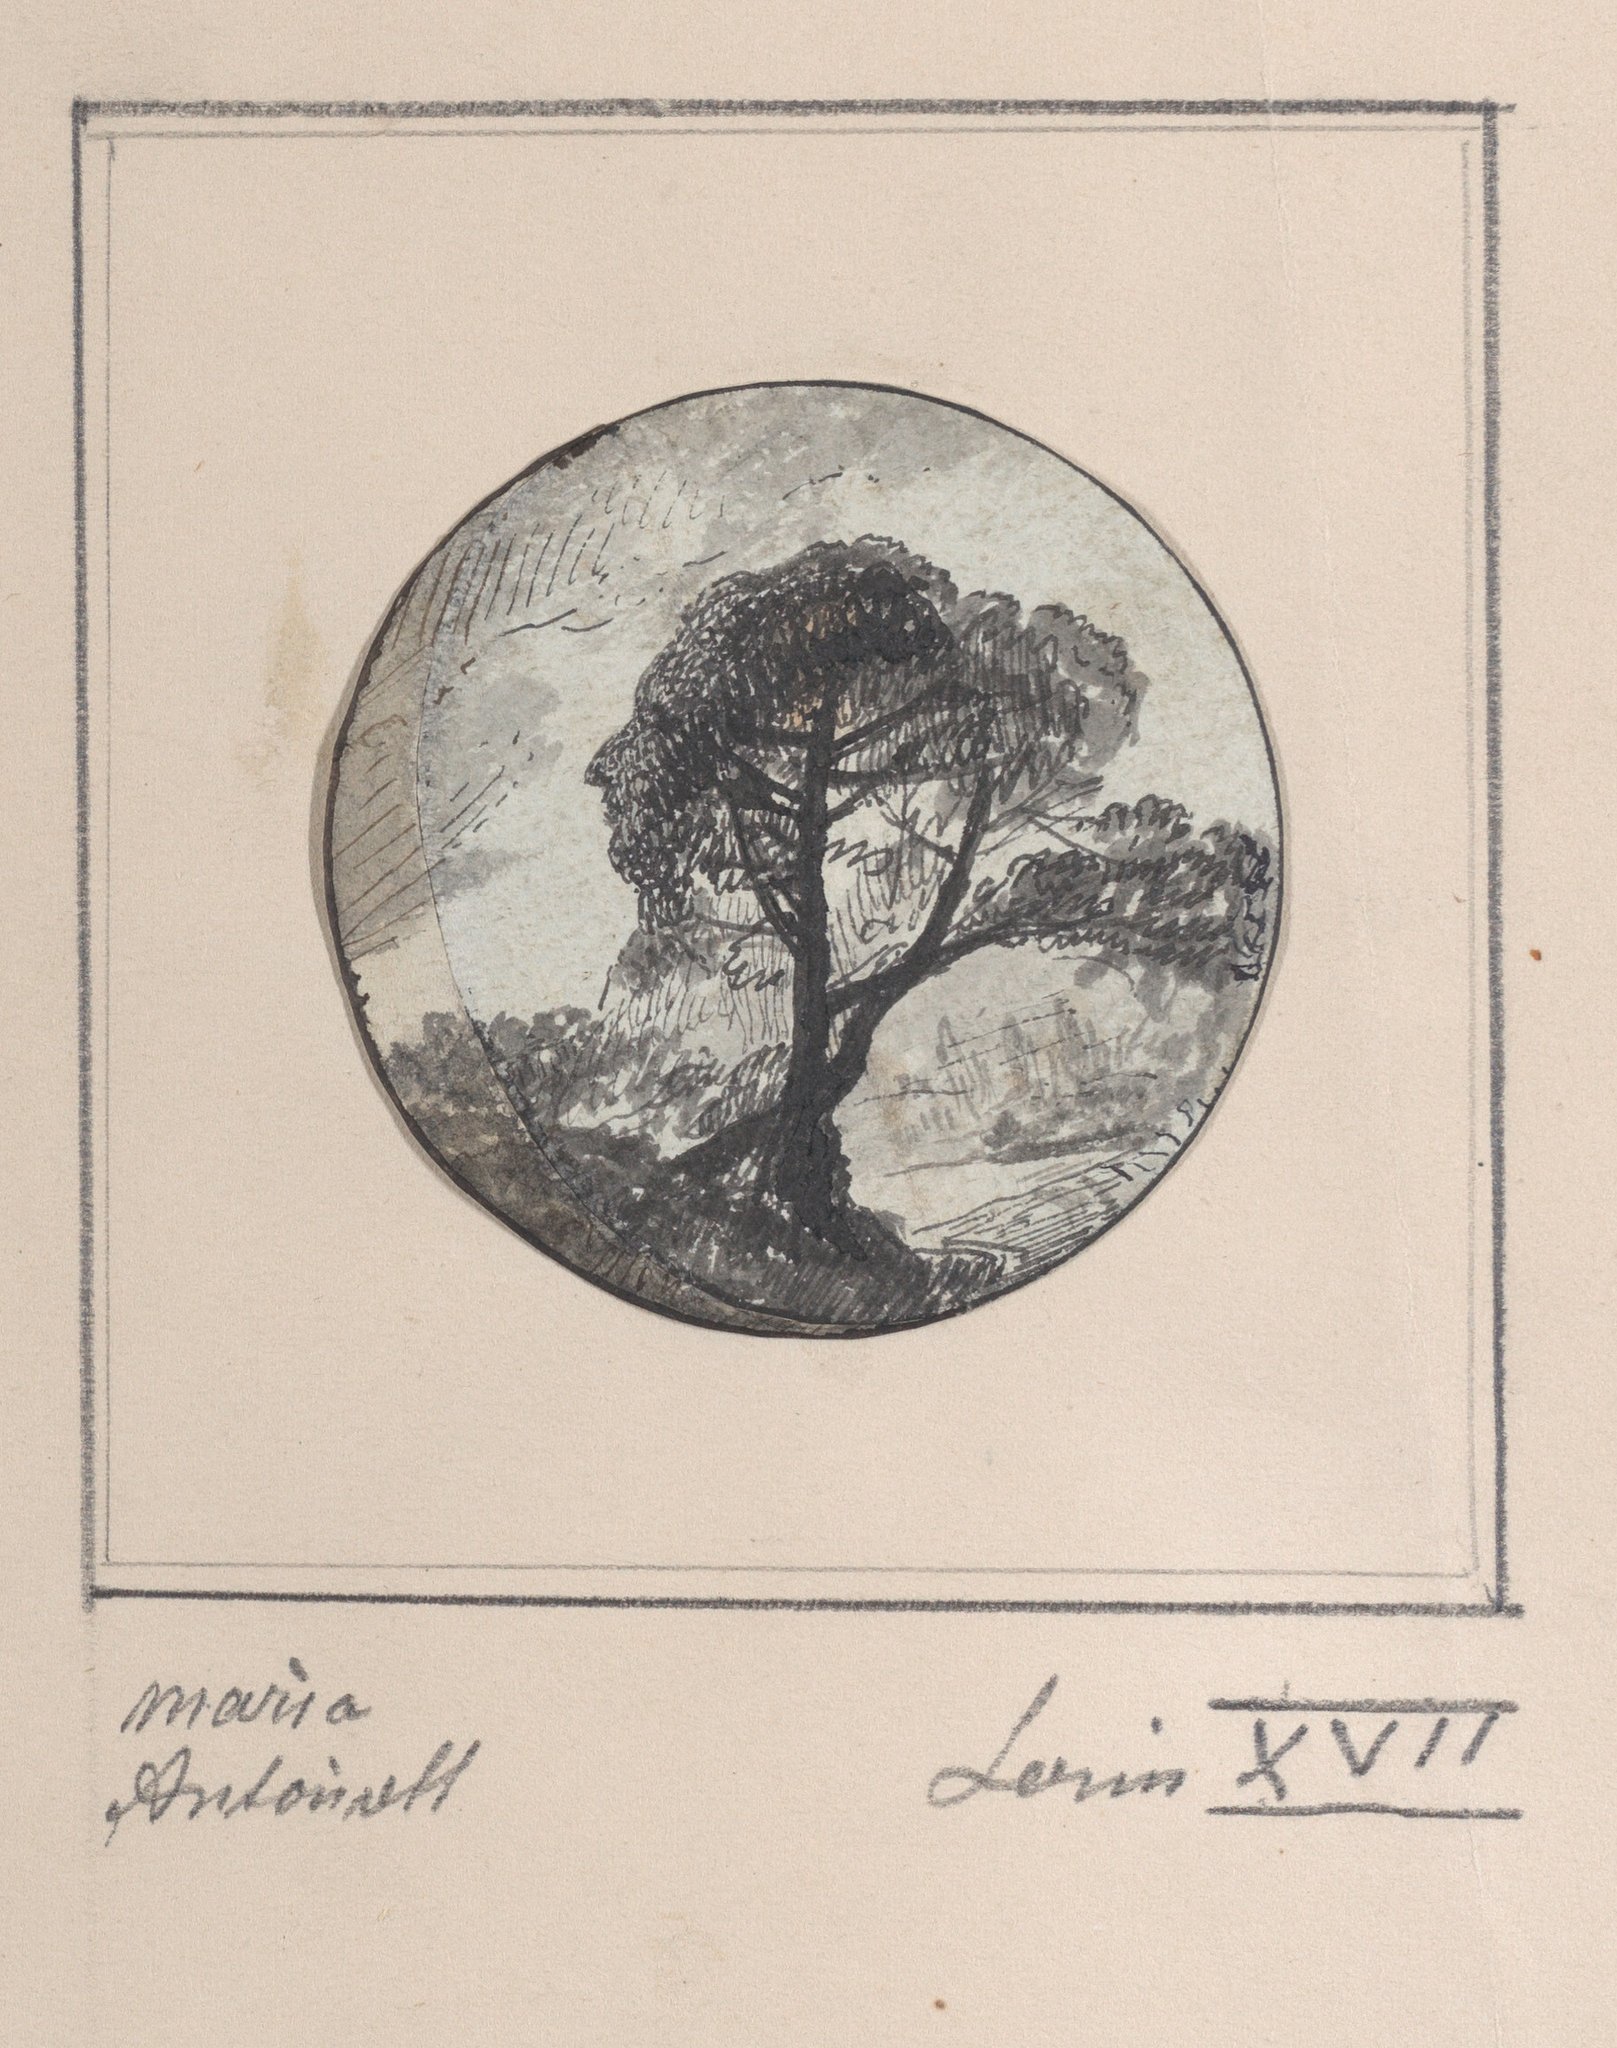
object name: print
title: Landscape with hidden silhouettes of Marie Antoinette and the Dauphin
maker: Anonymous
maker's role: artist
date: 1794-1815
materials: ink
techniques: pen, wash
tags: marie antoinette,trees